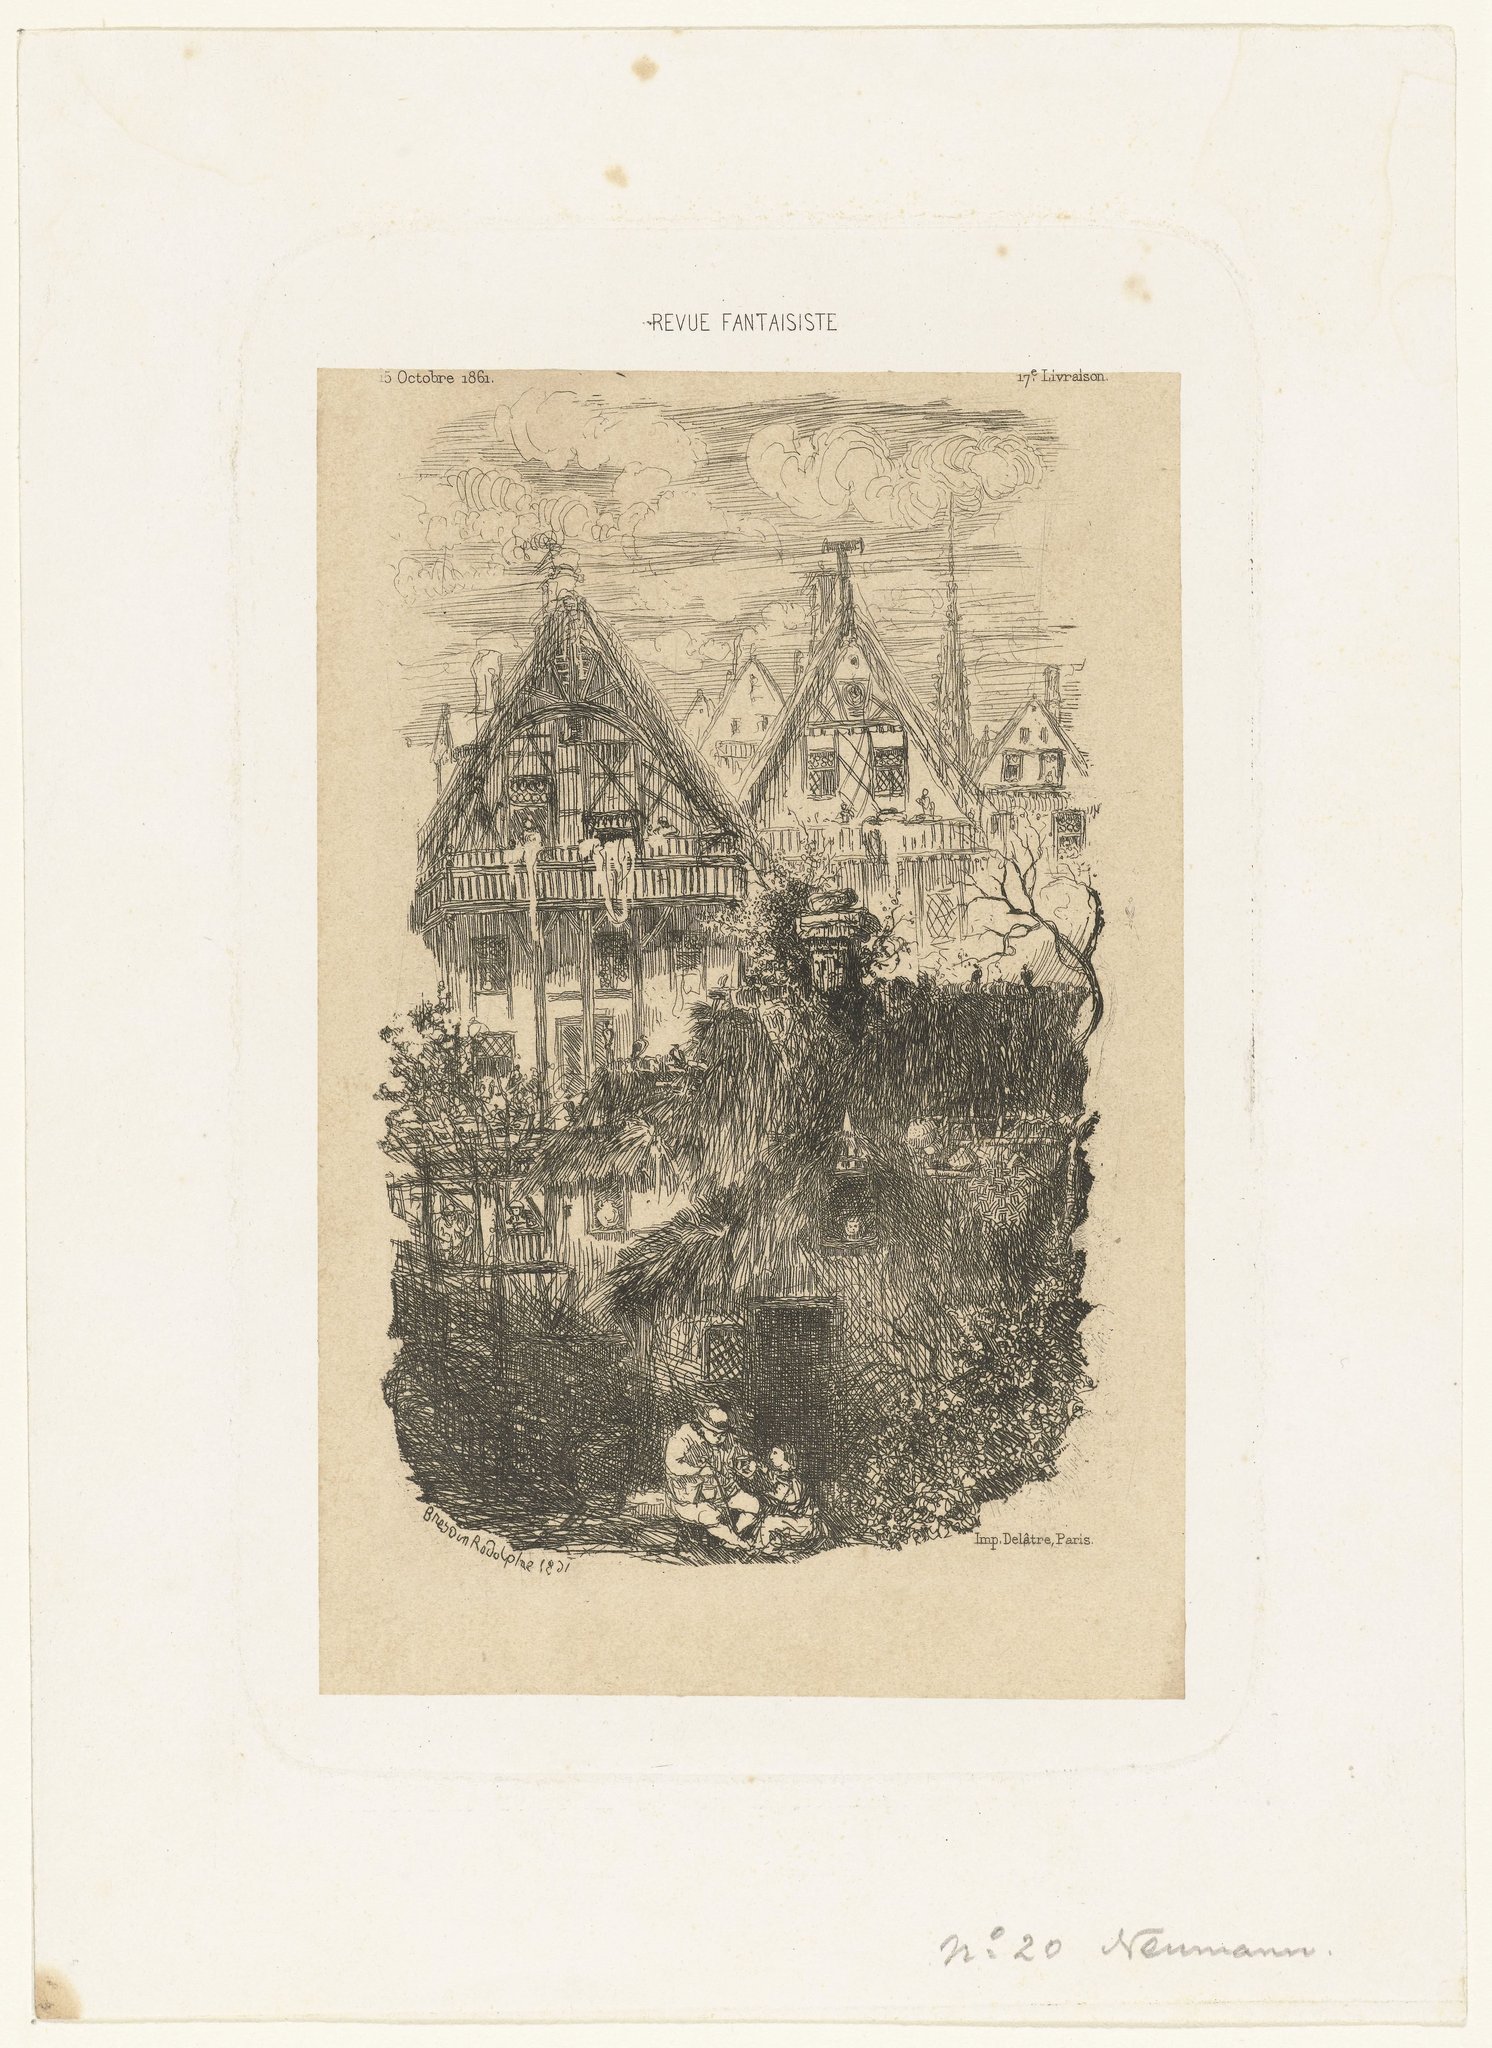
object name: print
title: Wijk met vakwerkhuizen in dorp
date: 1861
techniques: printmaking, etching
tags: urban housing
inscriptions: date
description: Wijk met vakwerkhuizen in een dorp. Een man en vrouw zitten voor een open deur van een boerderij op de voorgrond.